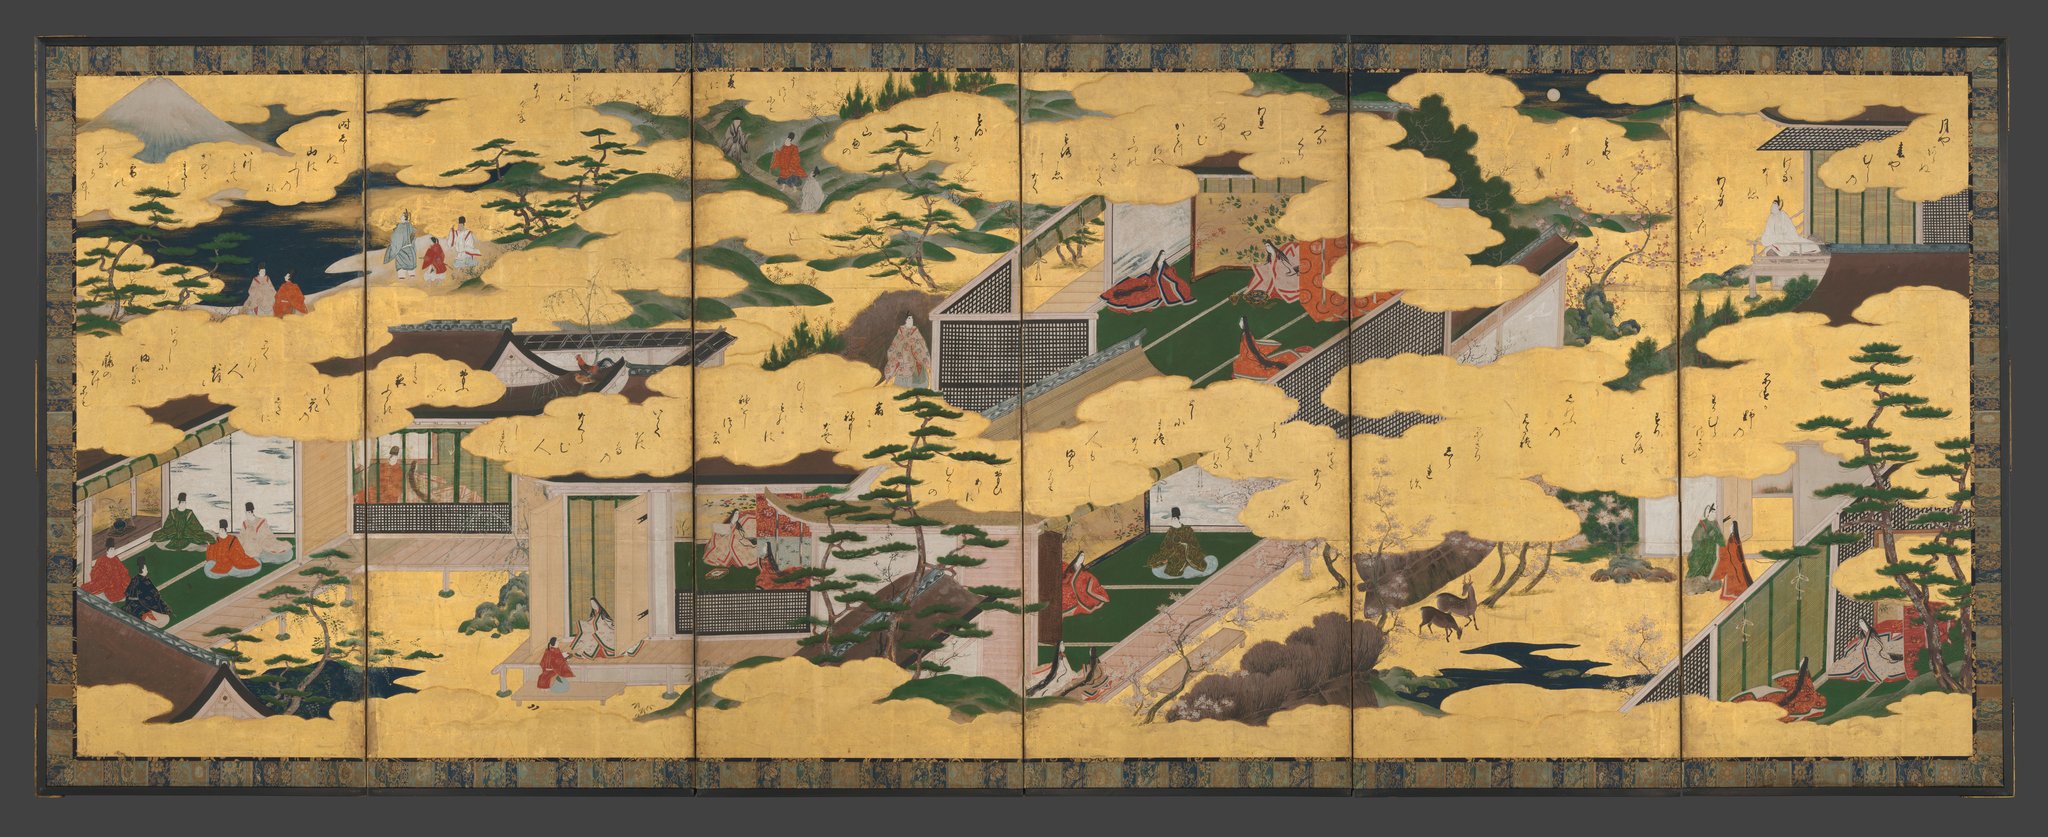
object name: screen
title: Scenes from the Tales of Ise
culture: japanese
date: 1601-1650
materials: gold, ink, panel, paper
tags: human figures,houses,landscapes,trees